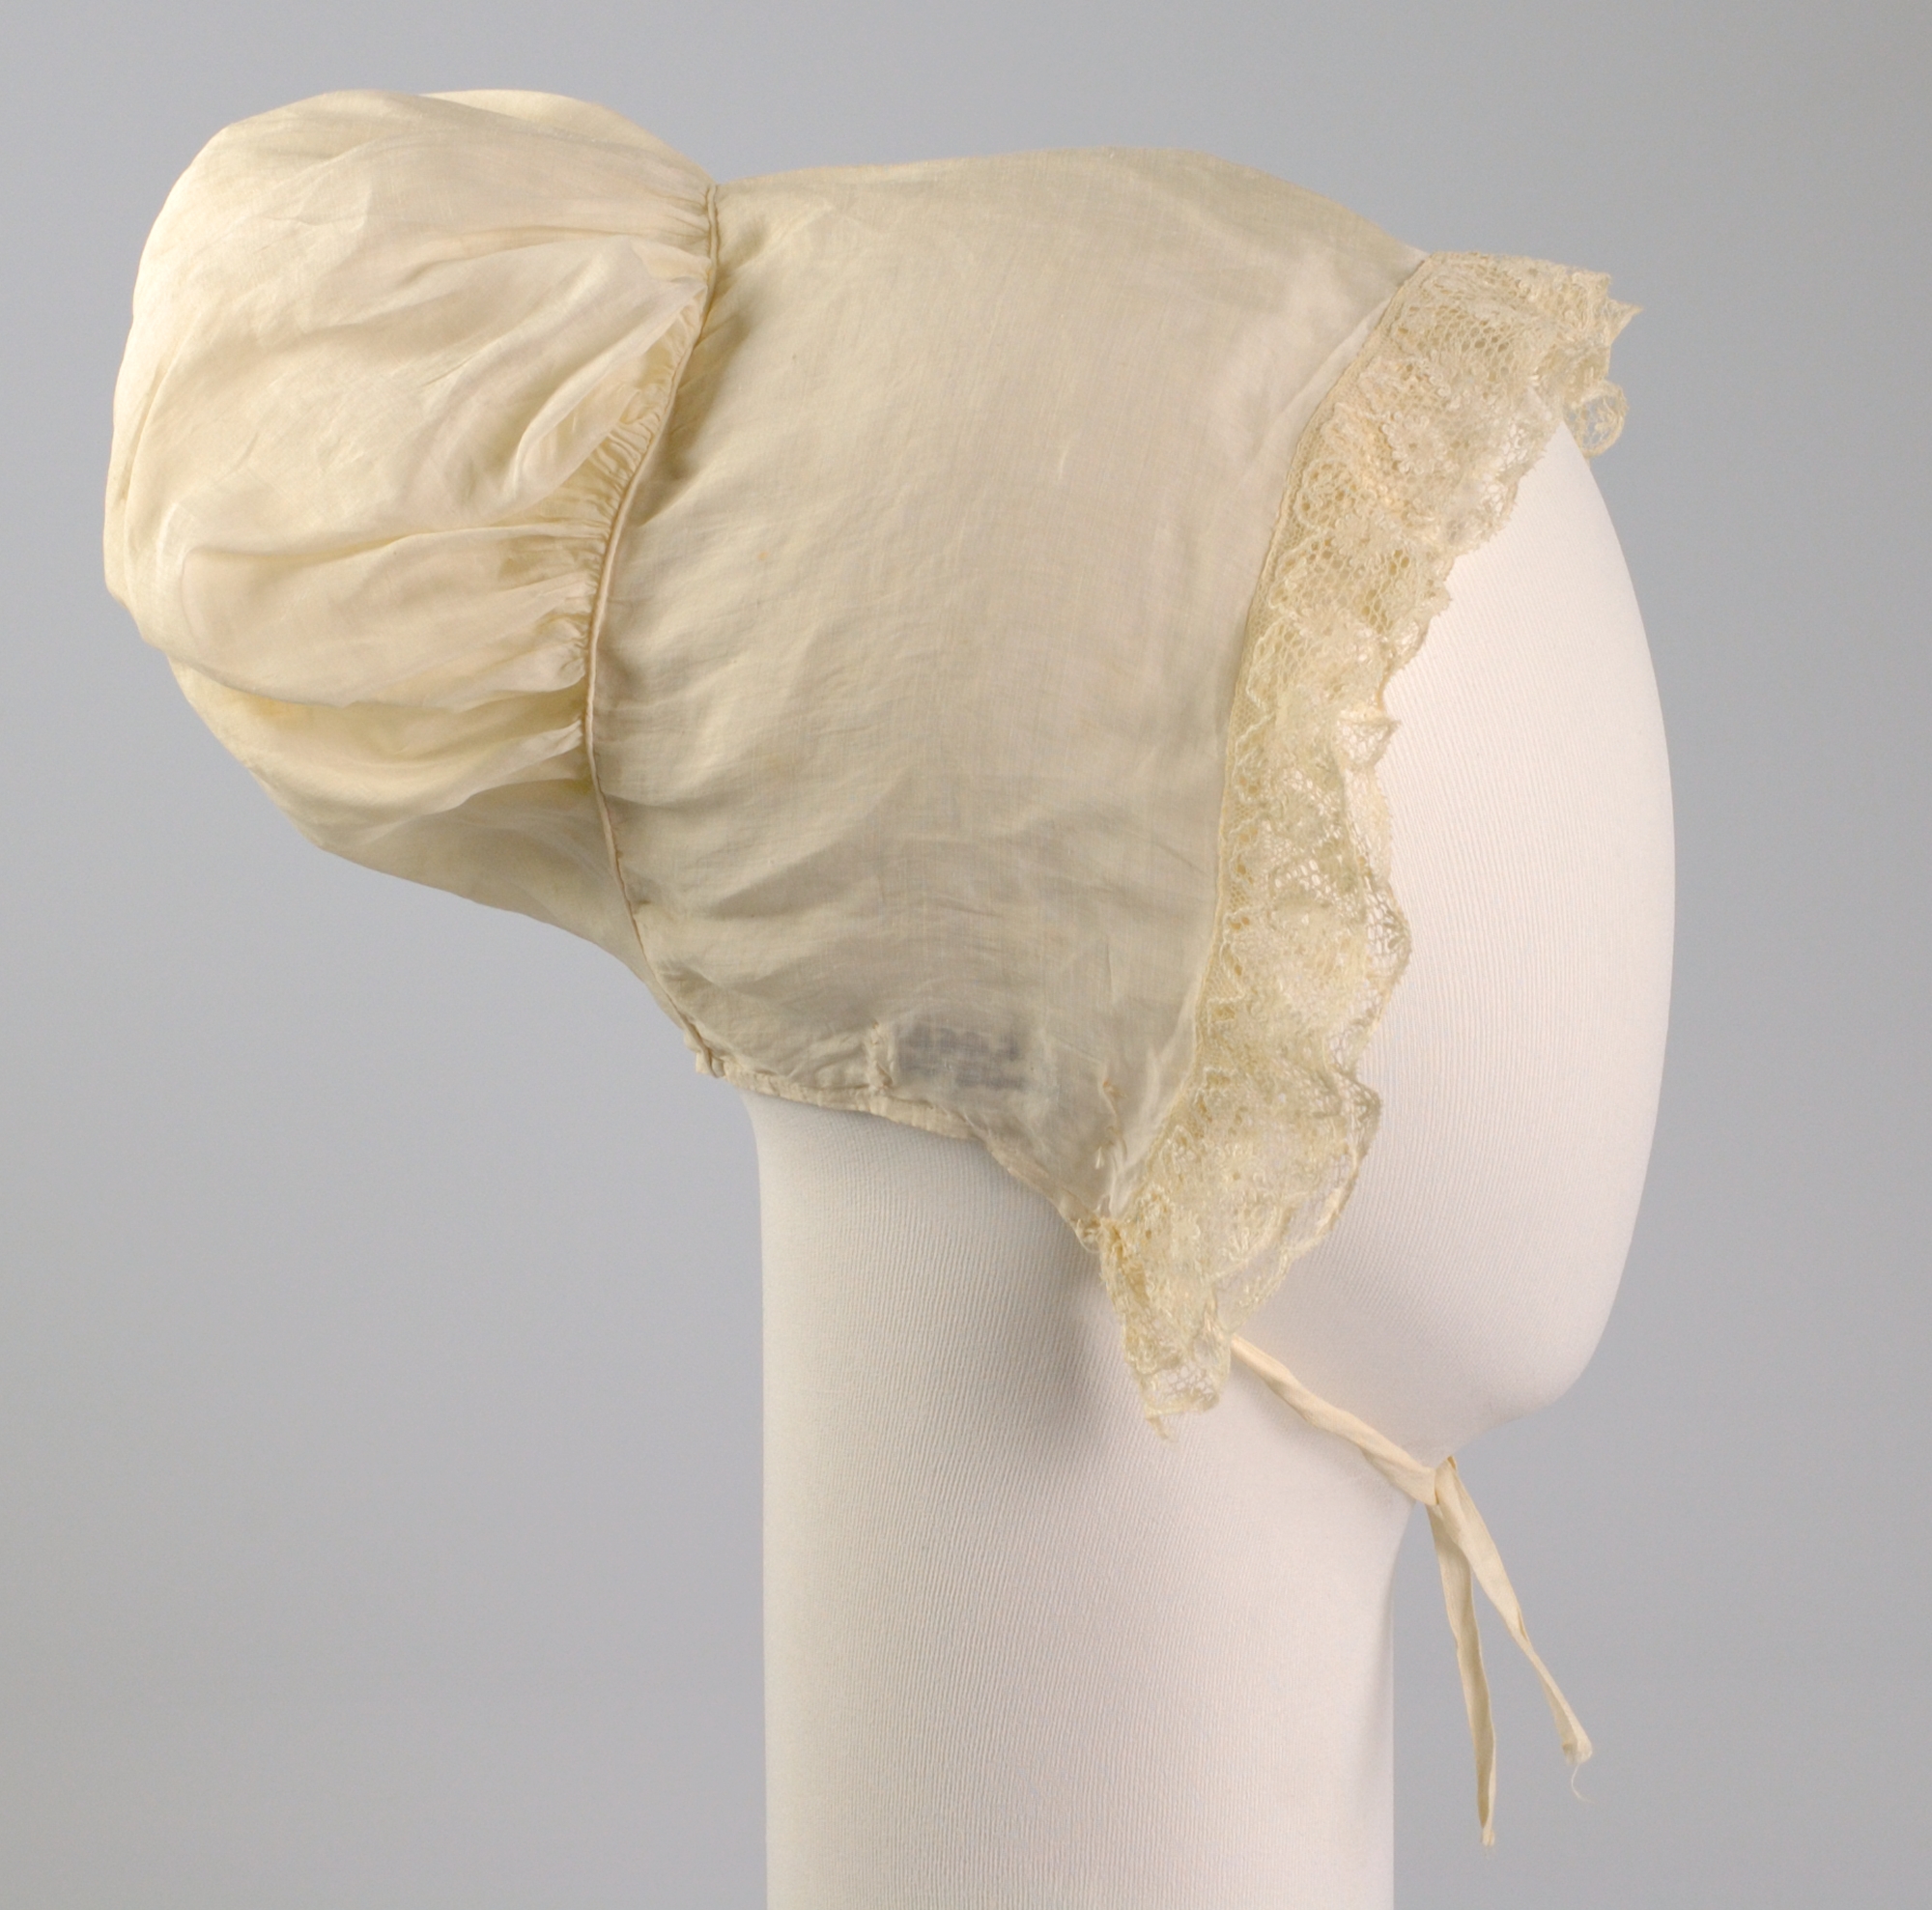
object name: nightcap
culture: american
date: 1835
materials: linen